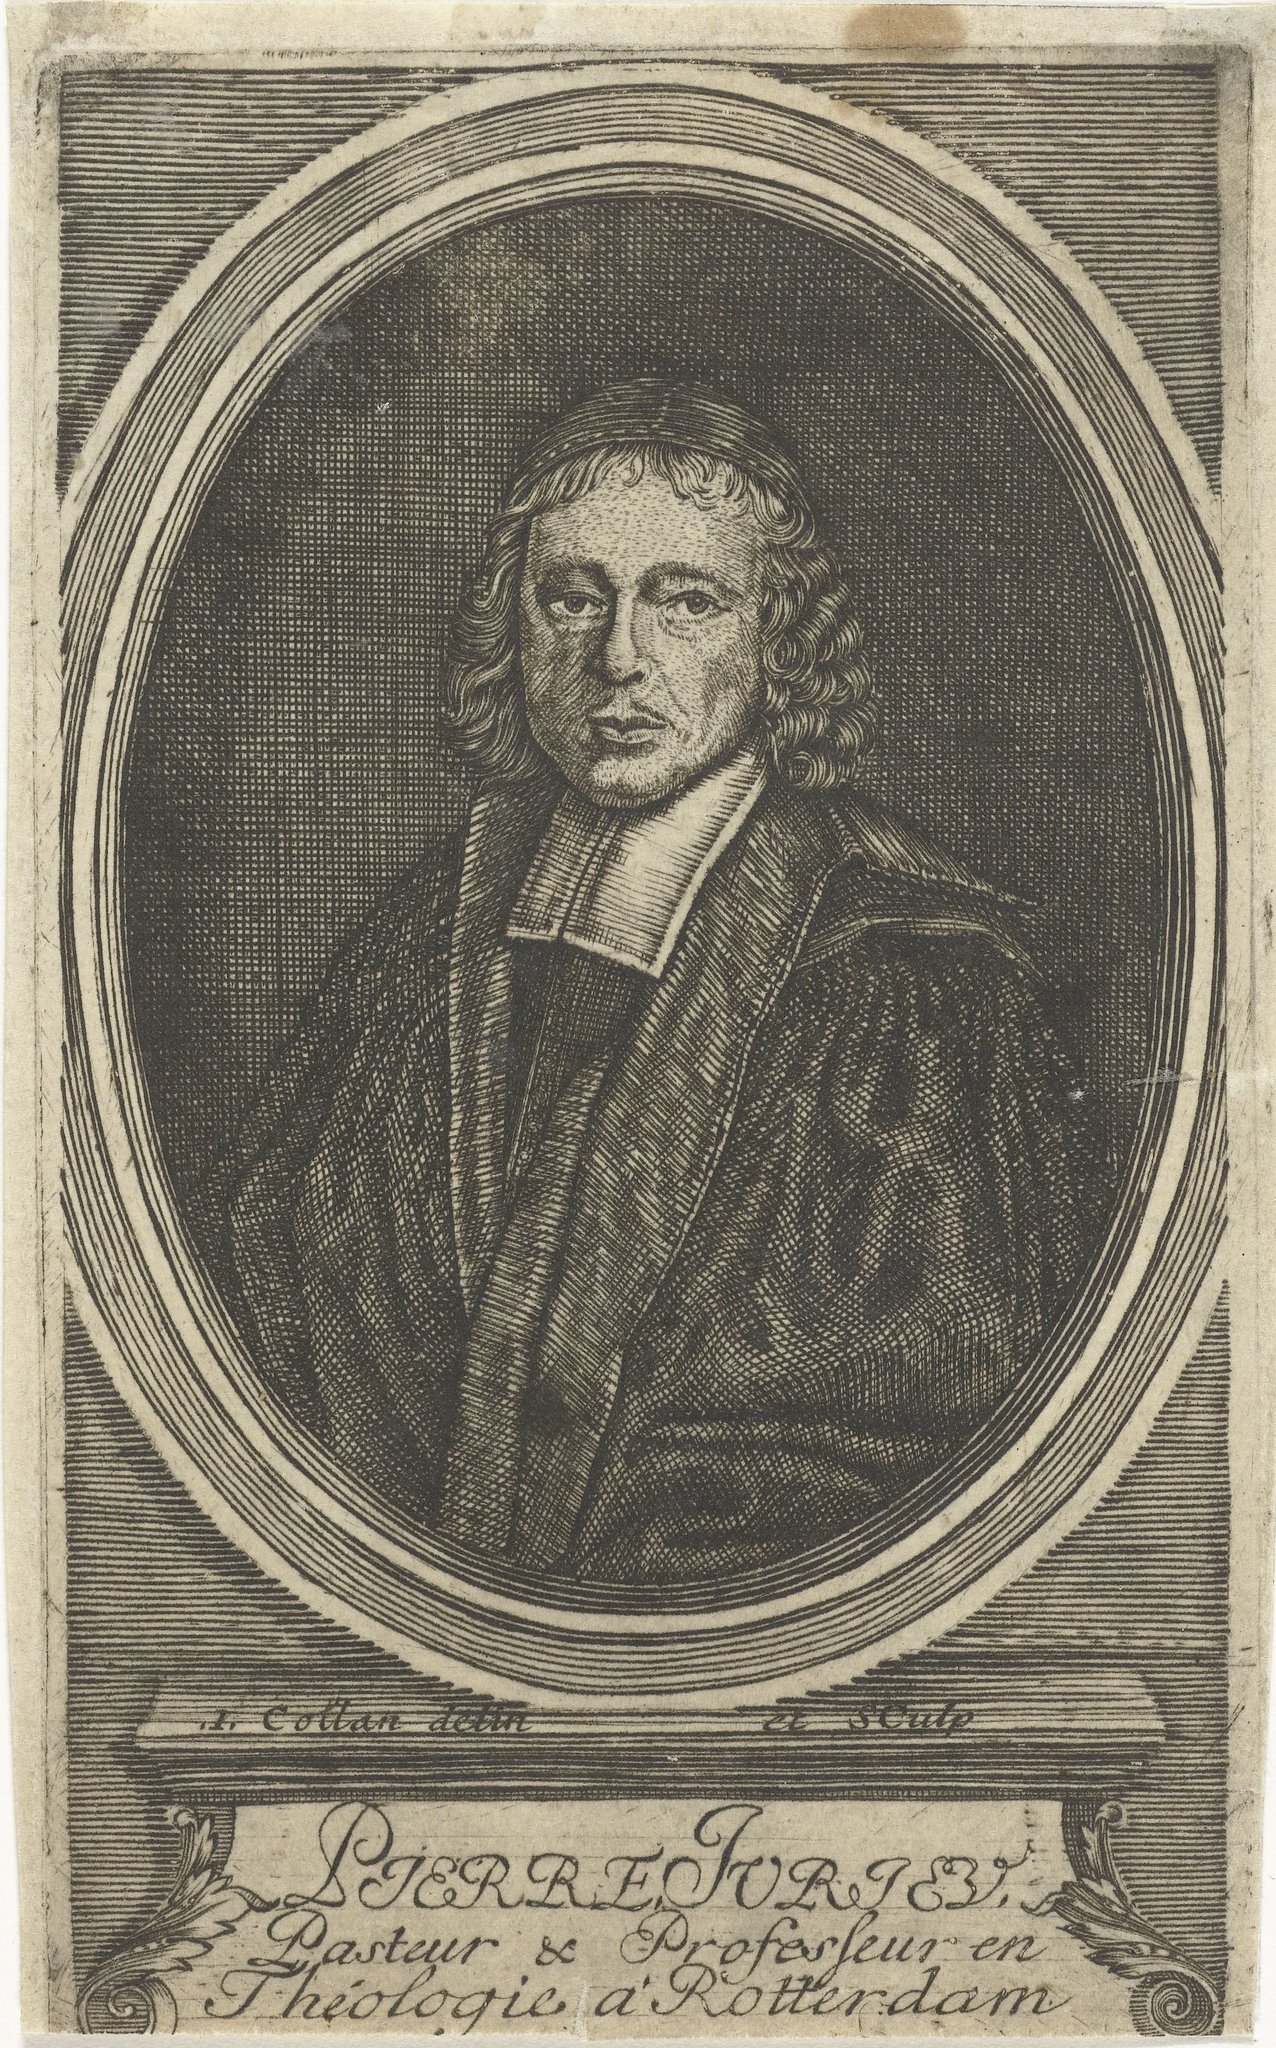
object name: print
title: Portret van Pierre Jurieu, predikant van de Waalse kerk te Rotterdam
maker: jacques collan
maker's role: print maker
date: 1702-1728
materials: paper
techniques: engraving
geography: rotterdam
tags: predikant, theoloog, hoogleraar, pierre jurieu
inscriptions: collector's mark: Lugt 2228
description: Borstbeeld van de predikant Pierre Jurieu in ovaal. Onder het portret op een sokkel zijn naam en functie.